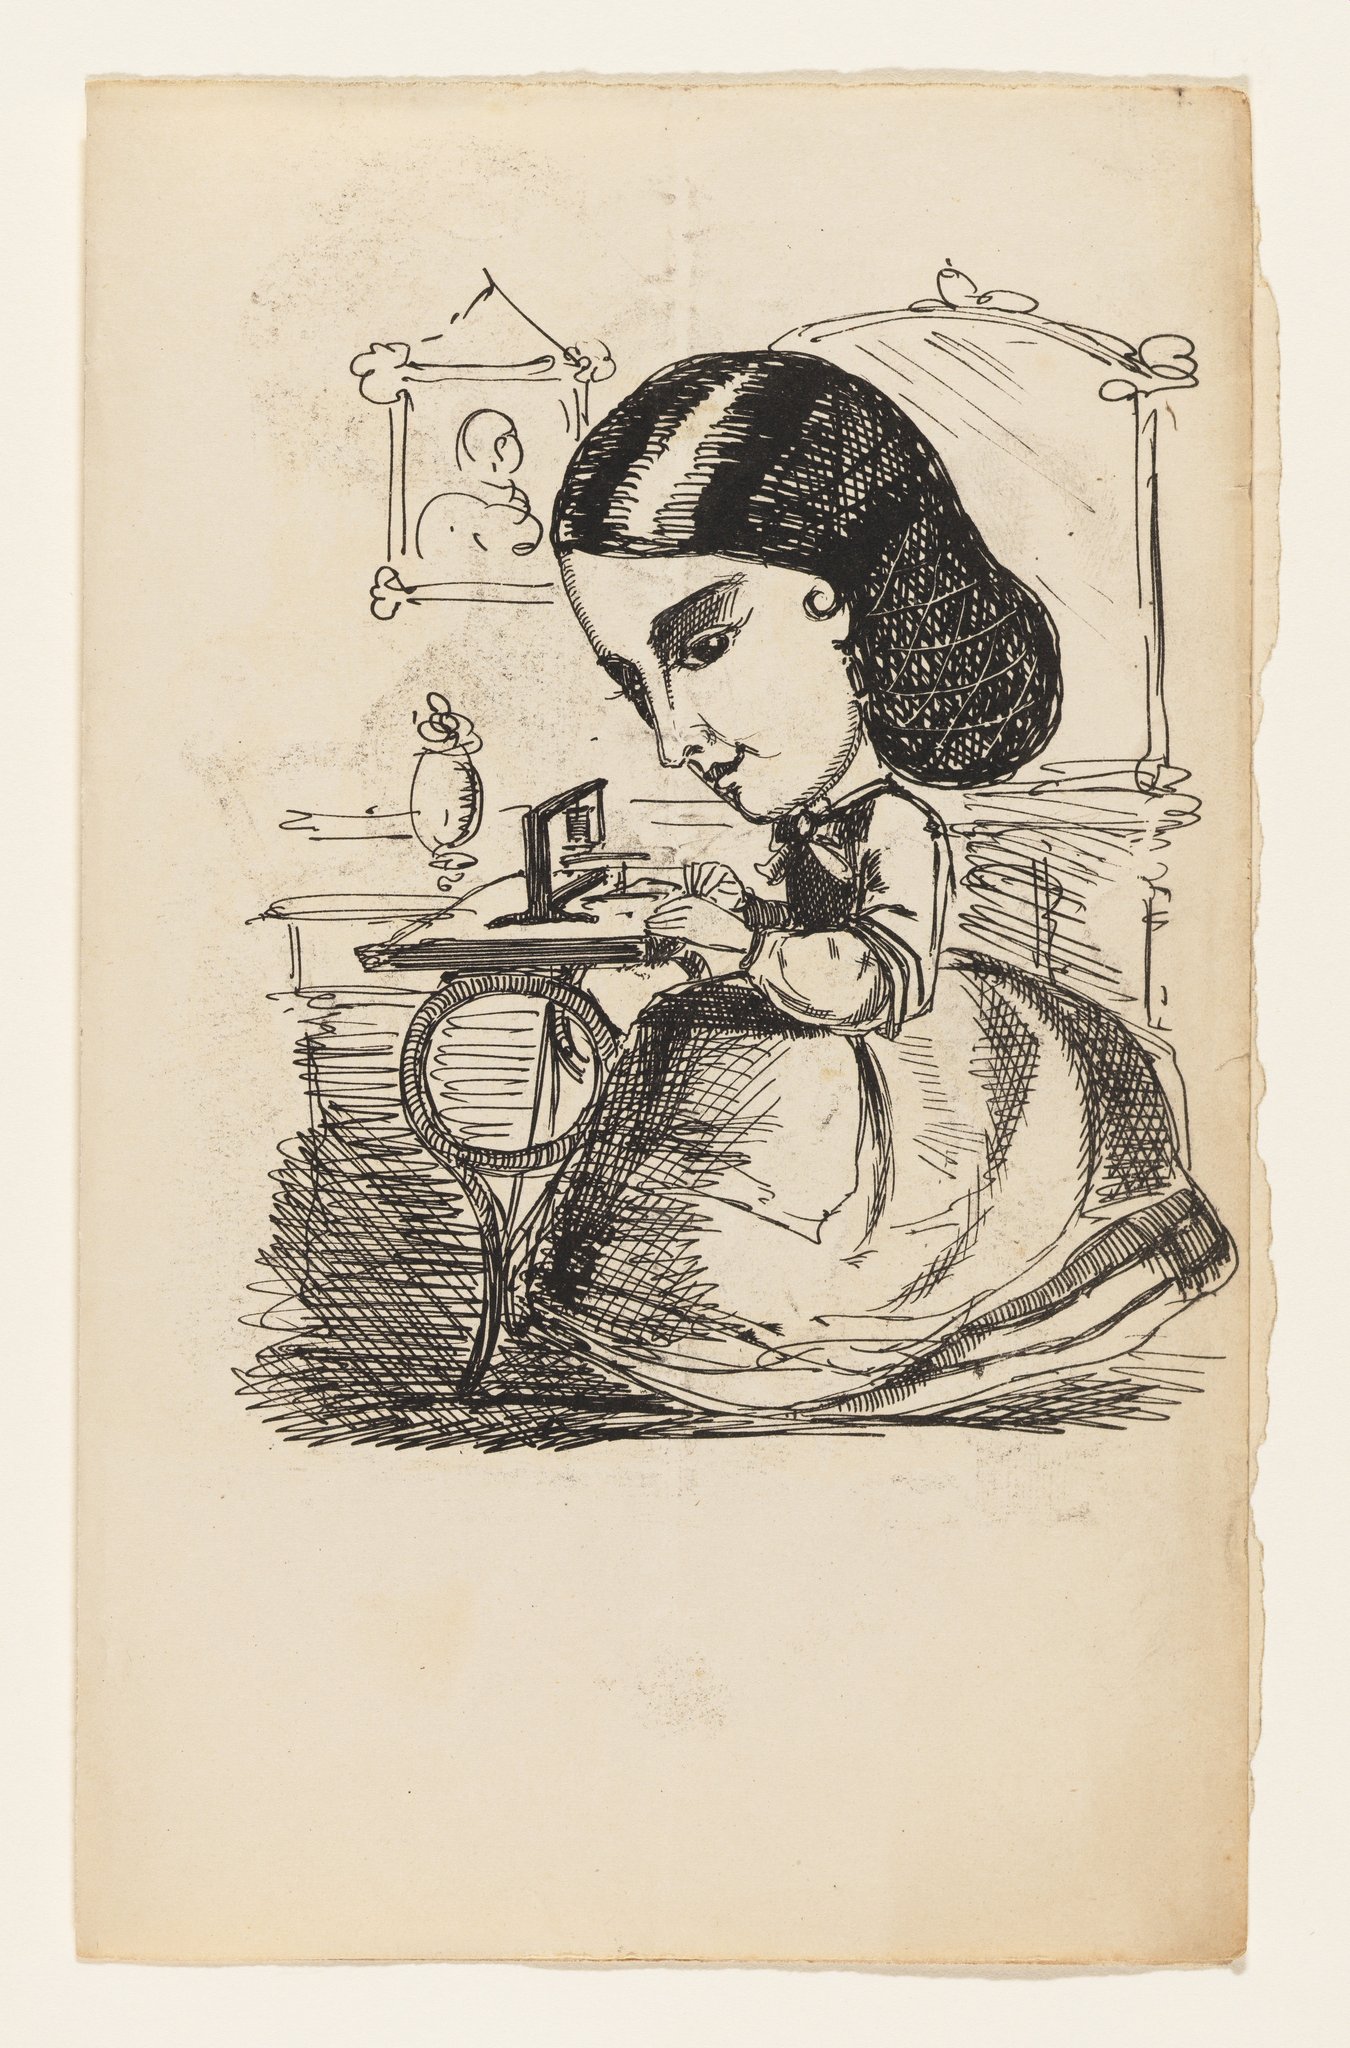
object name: drawing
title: Comic Valentine original illustration: Sewing Machine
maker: Anonymous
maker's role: artist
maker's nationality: british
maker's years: 1800-1899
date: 1860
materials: ink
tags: women,sewing